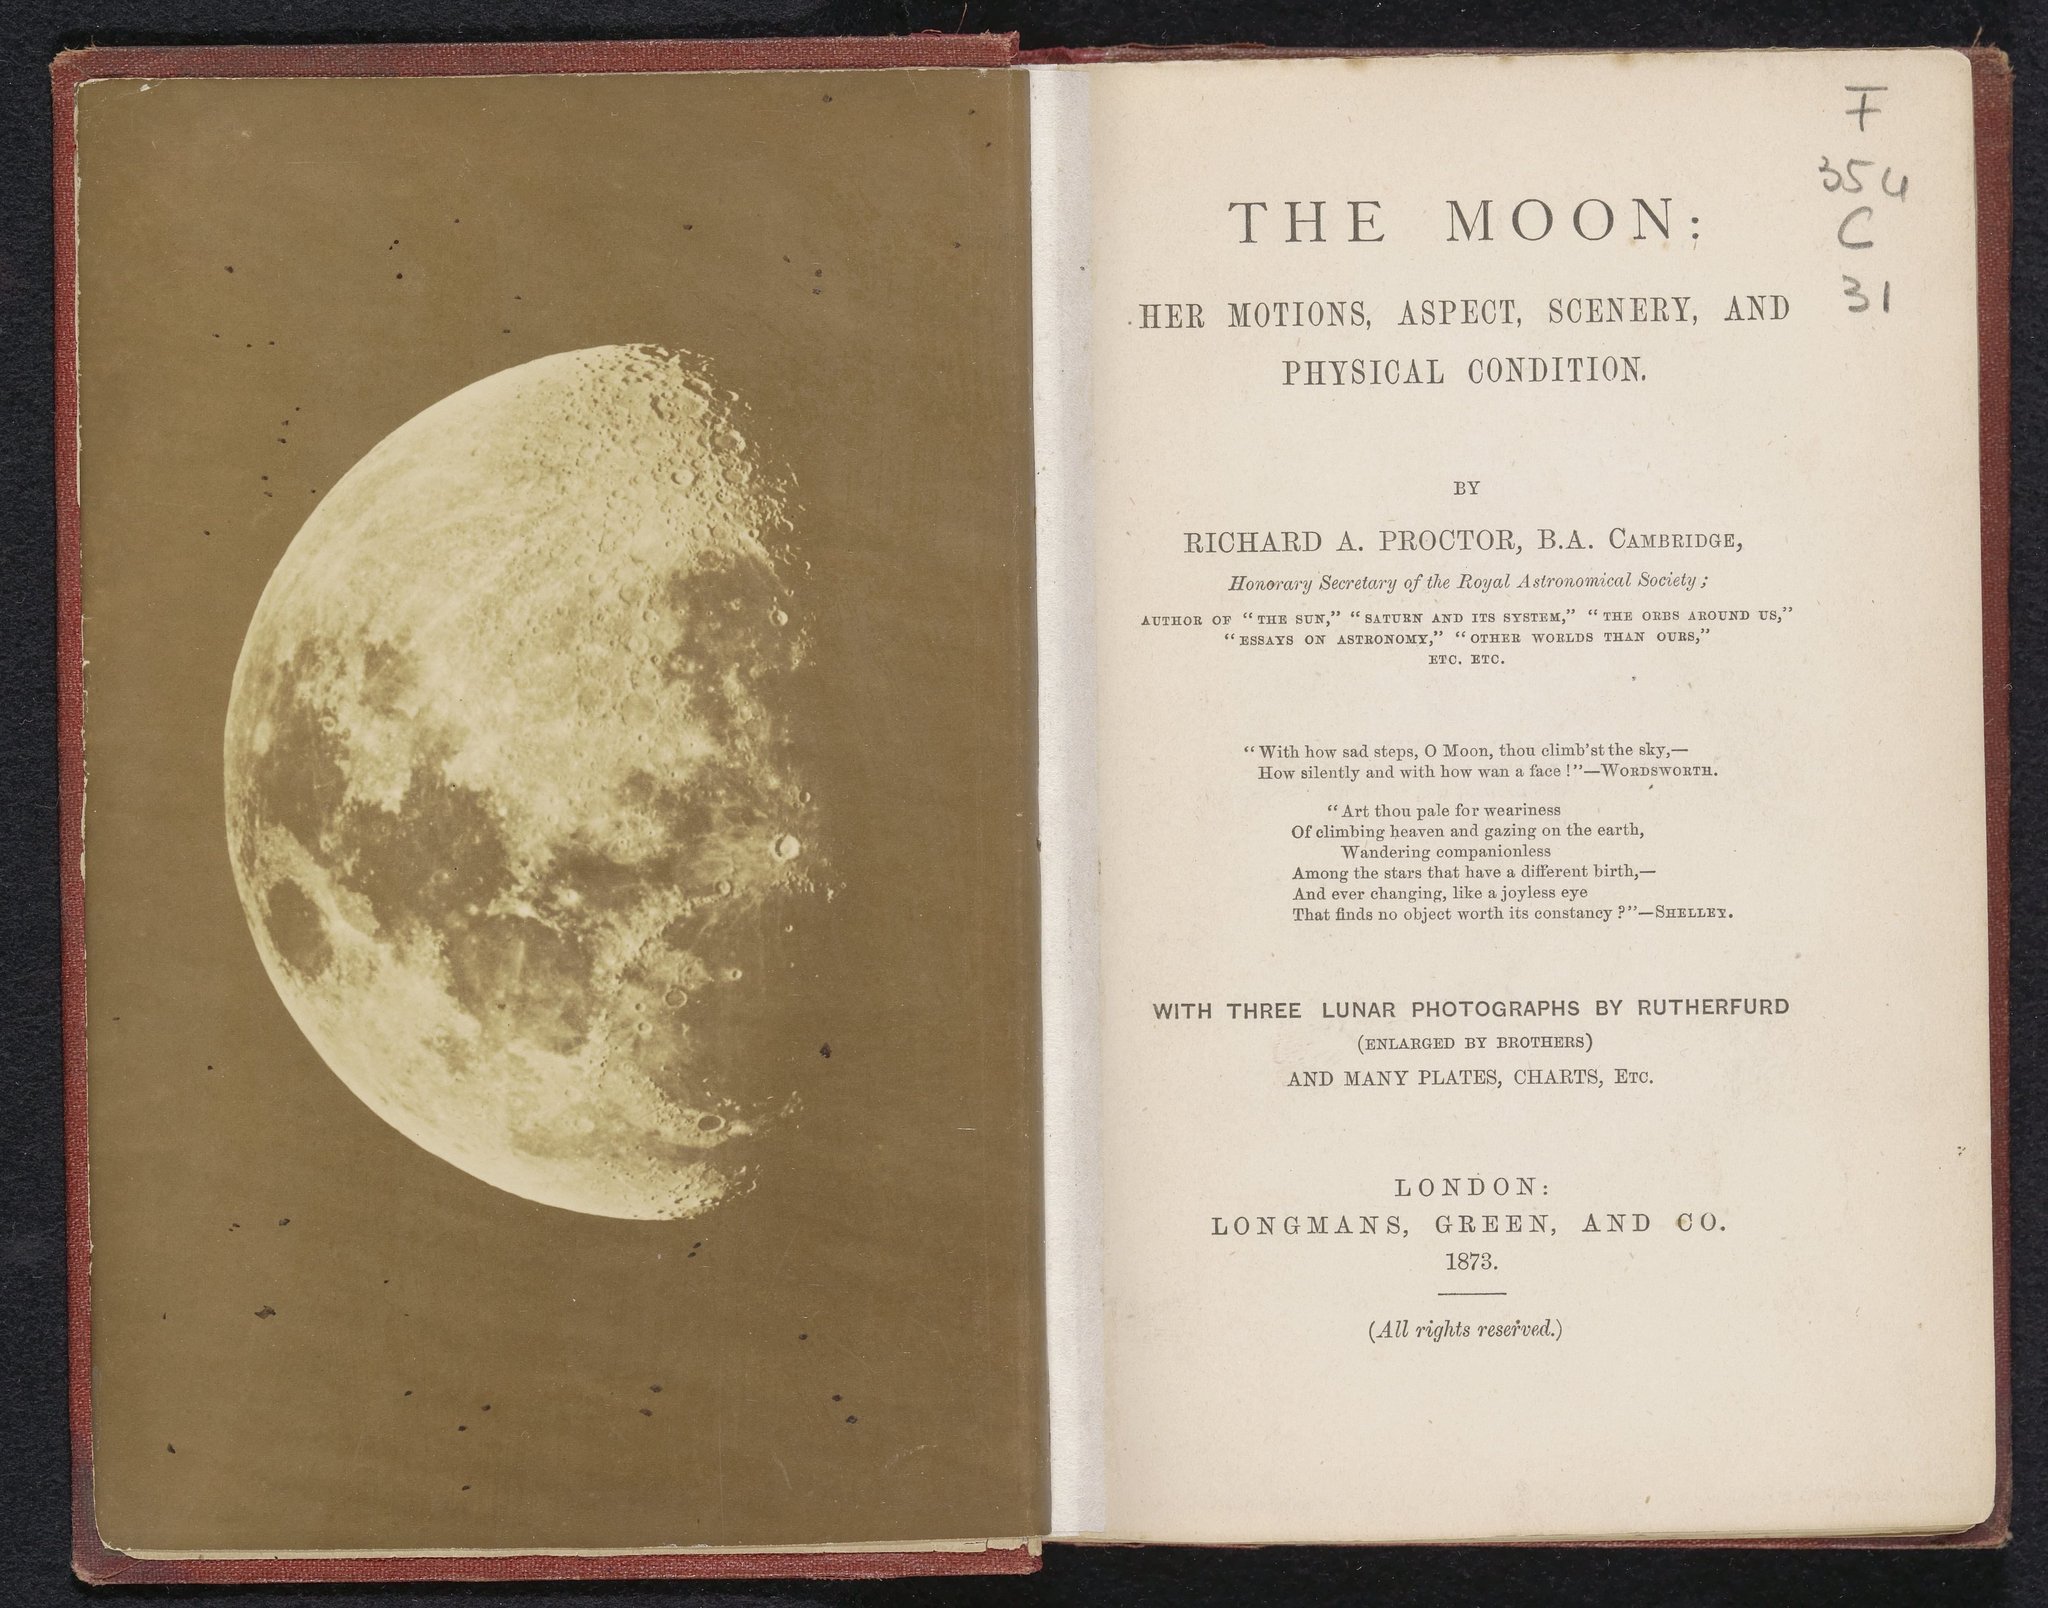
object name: photograph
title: Maan in het eerste kwartier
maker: lewis morris rutherfurd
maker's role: advocaat, astronoom, fotograaf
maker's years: 1816-1892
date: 1863-1873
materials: photographic support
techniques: albumen print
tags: waning moon, i.e. facing this way (, moon